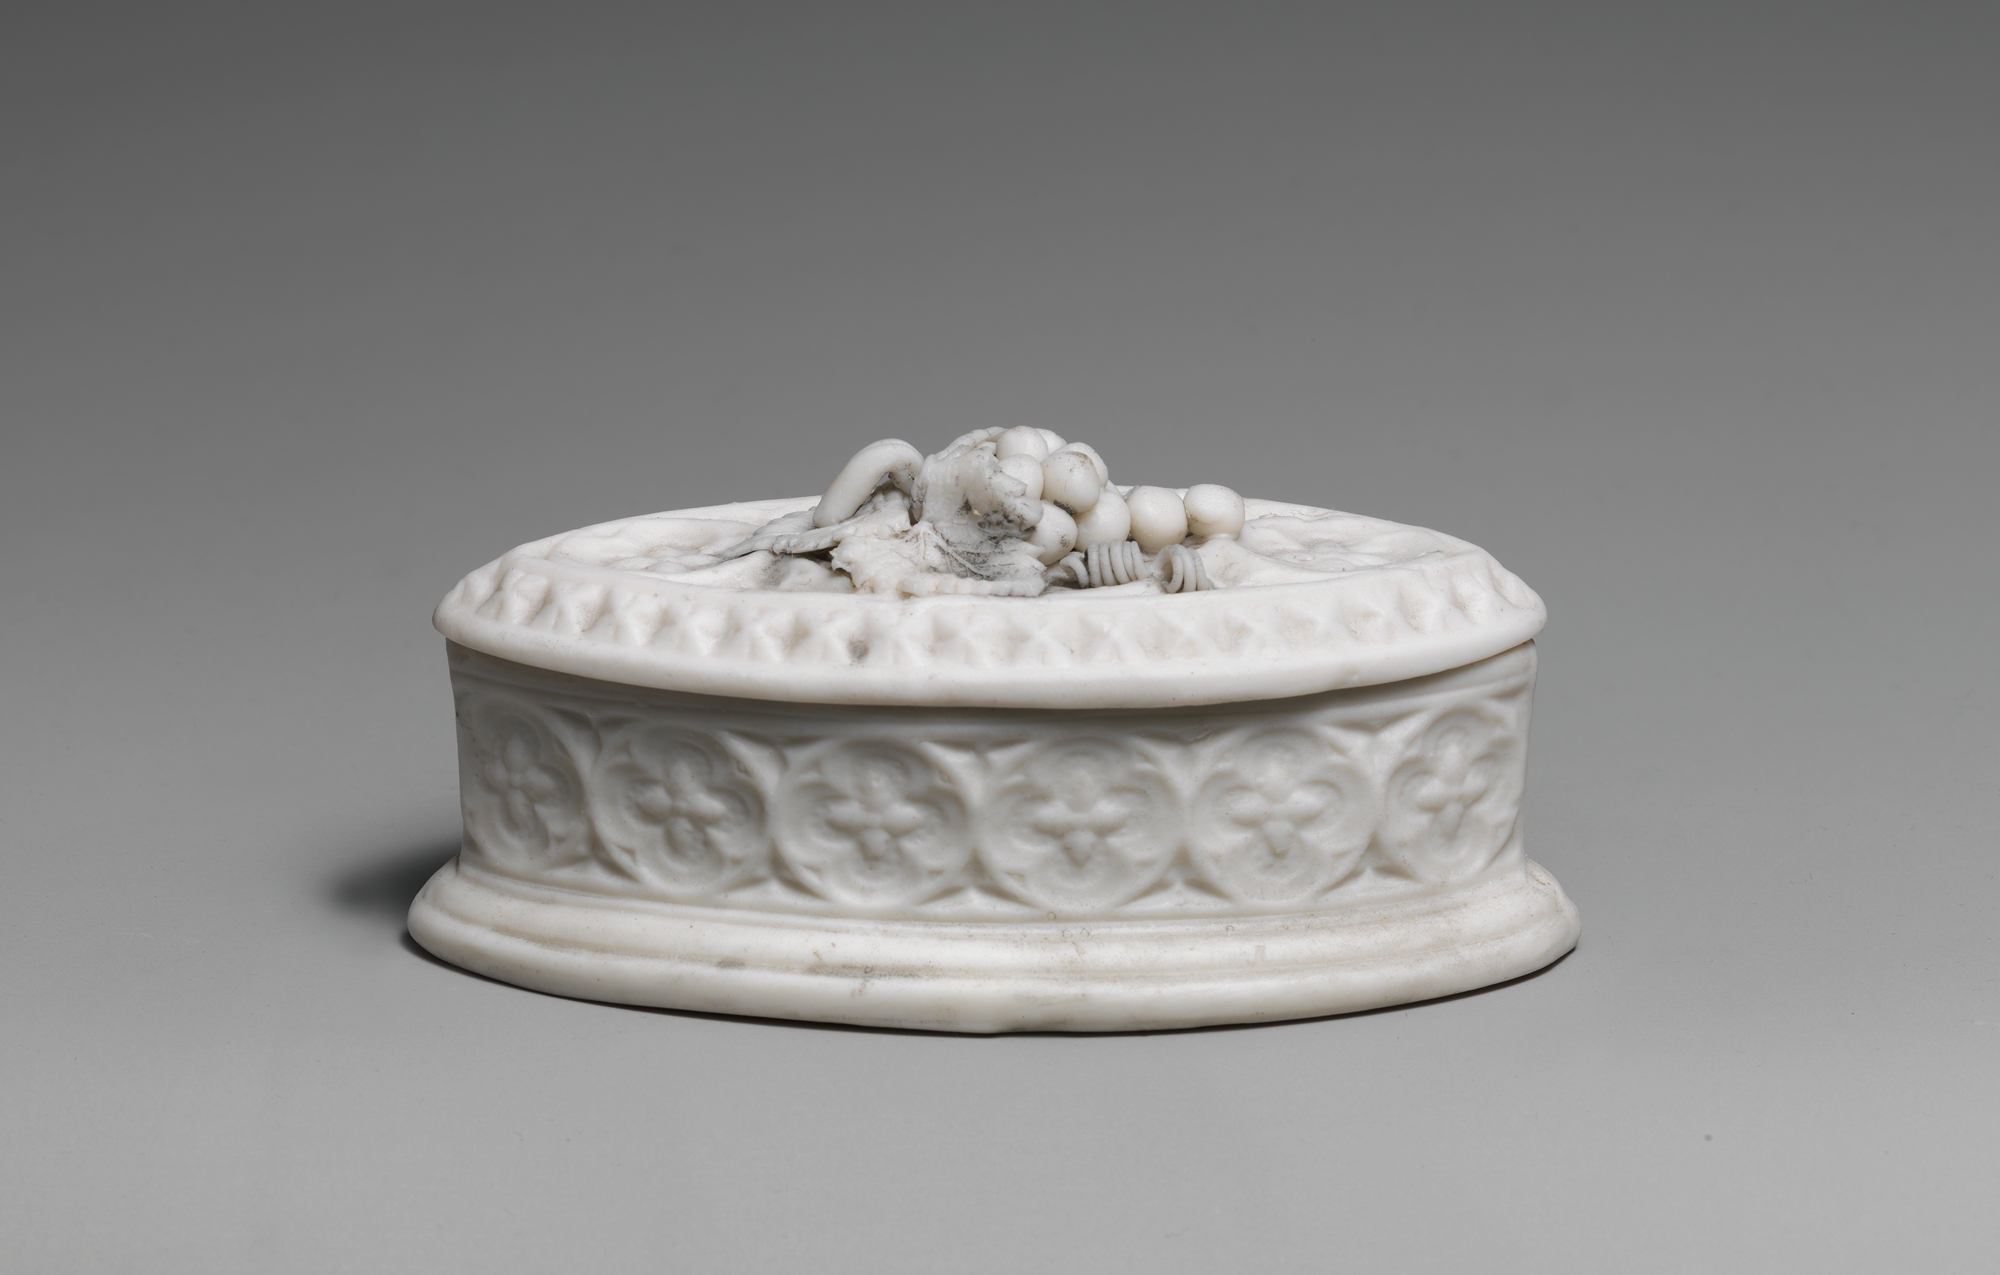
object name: box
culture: american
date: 1830-1870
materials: porcelain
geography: united states